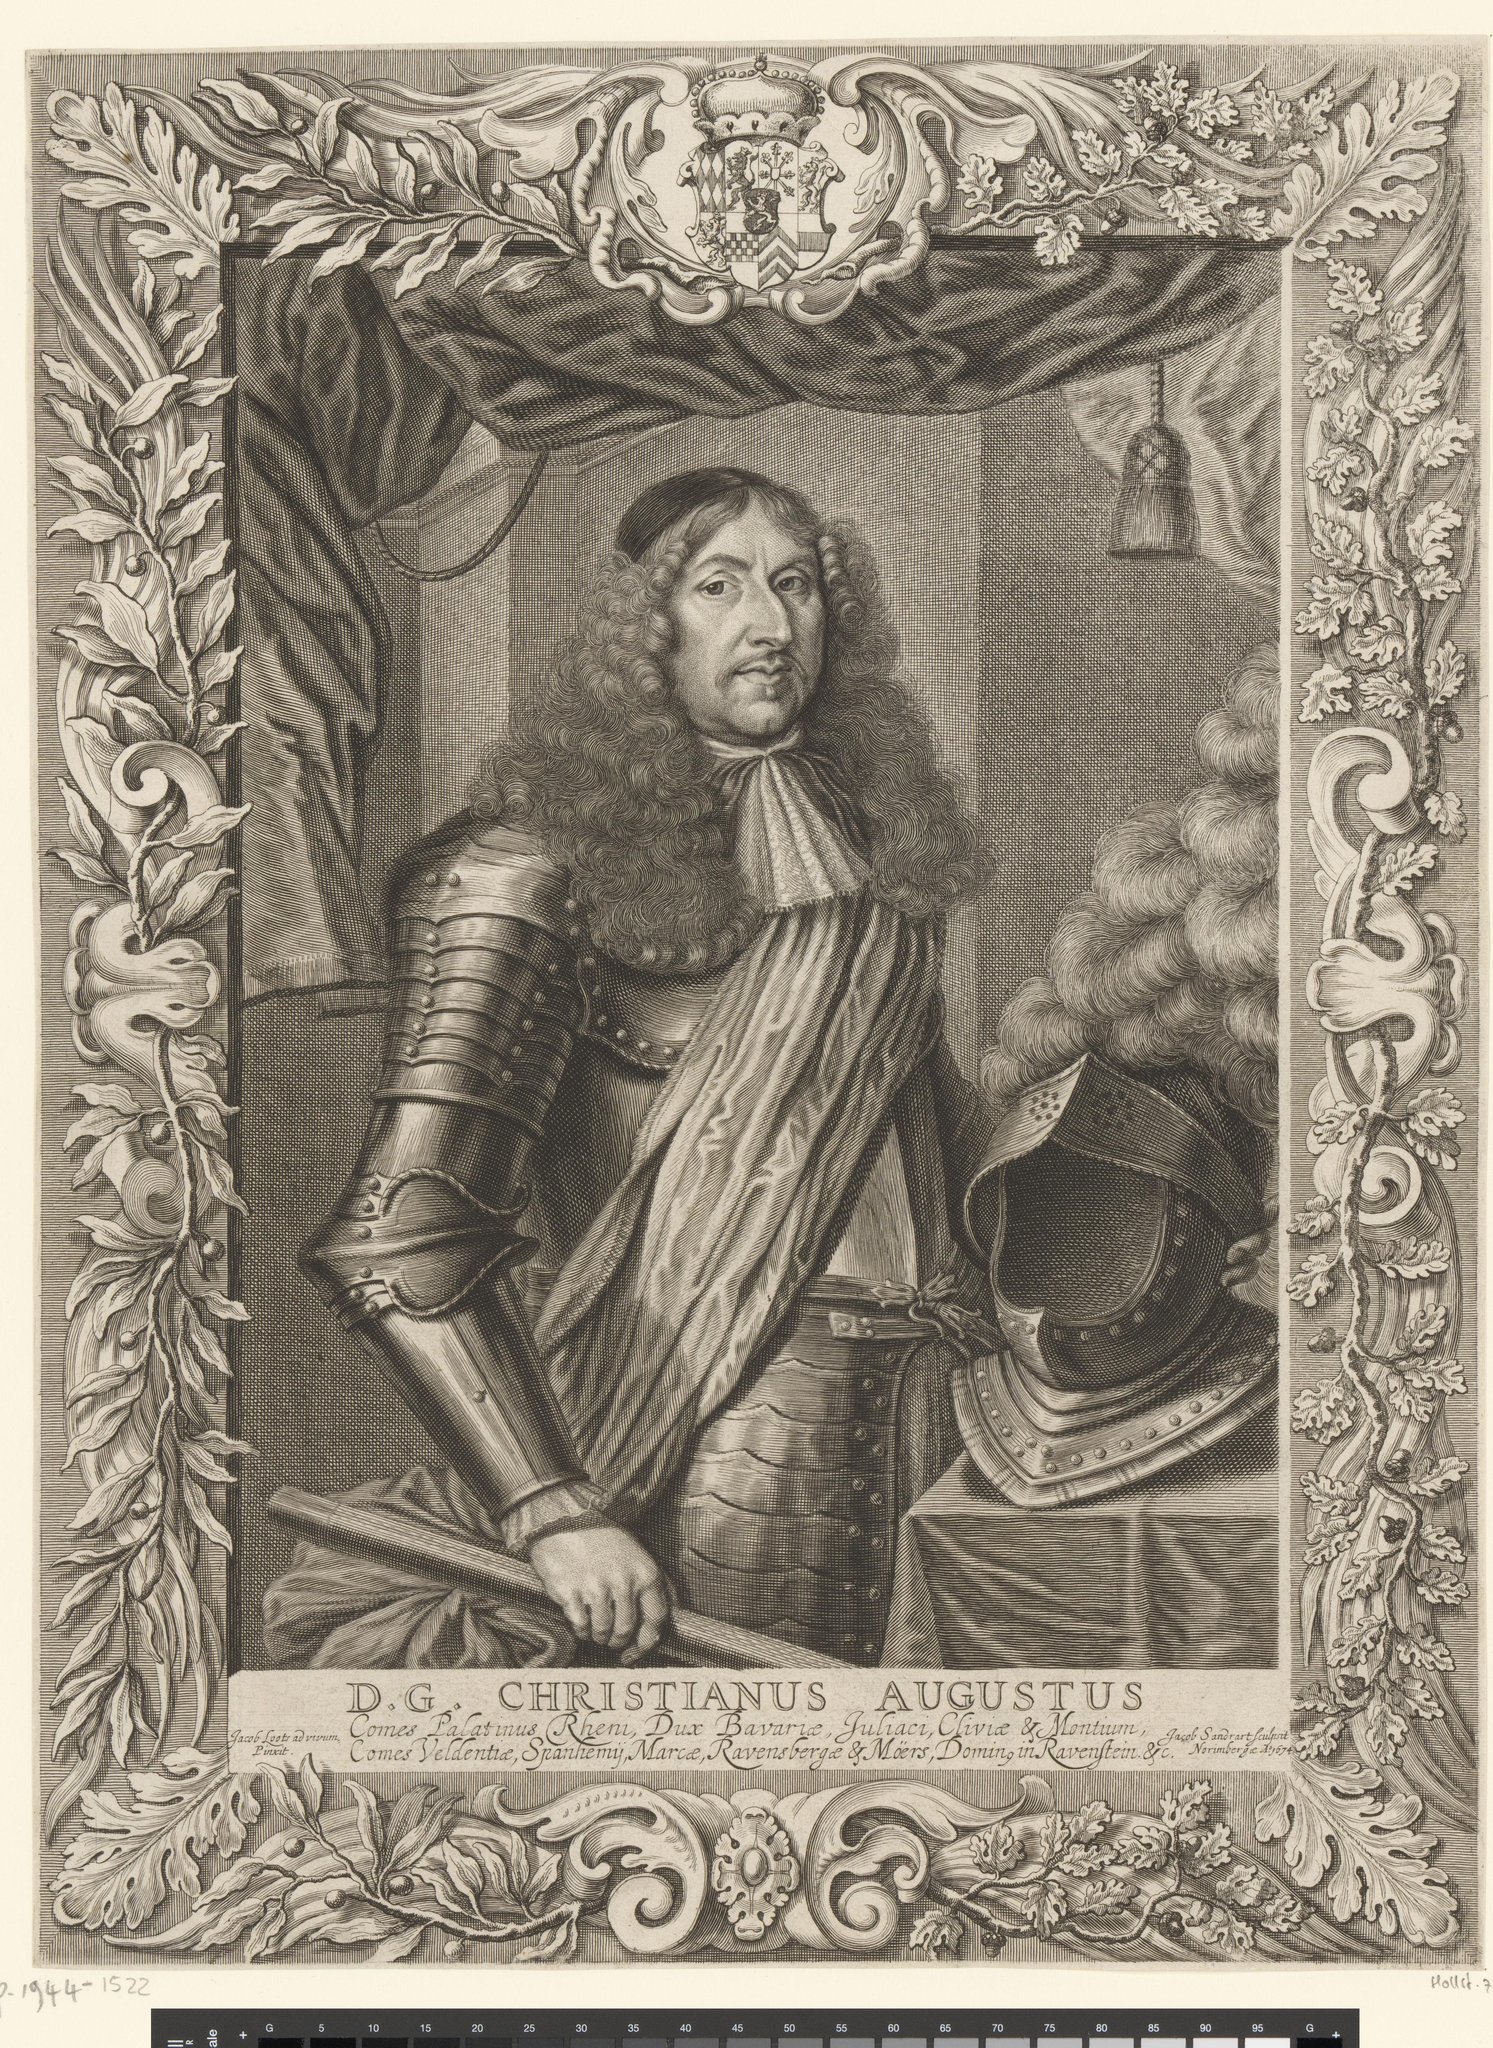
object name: print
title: Portret van Christianus Augustus, Pfalzgraf zu Sulzbach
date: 1674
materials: paper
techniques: engraving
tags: commander-in-chief, general, marshal, historical persons, armorial bearing, heraldry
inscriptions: collector's mark: Lugt 2228